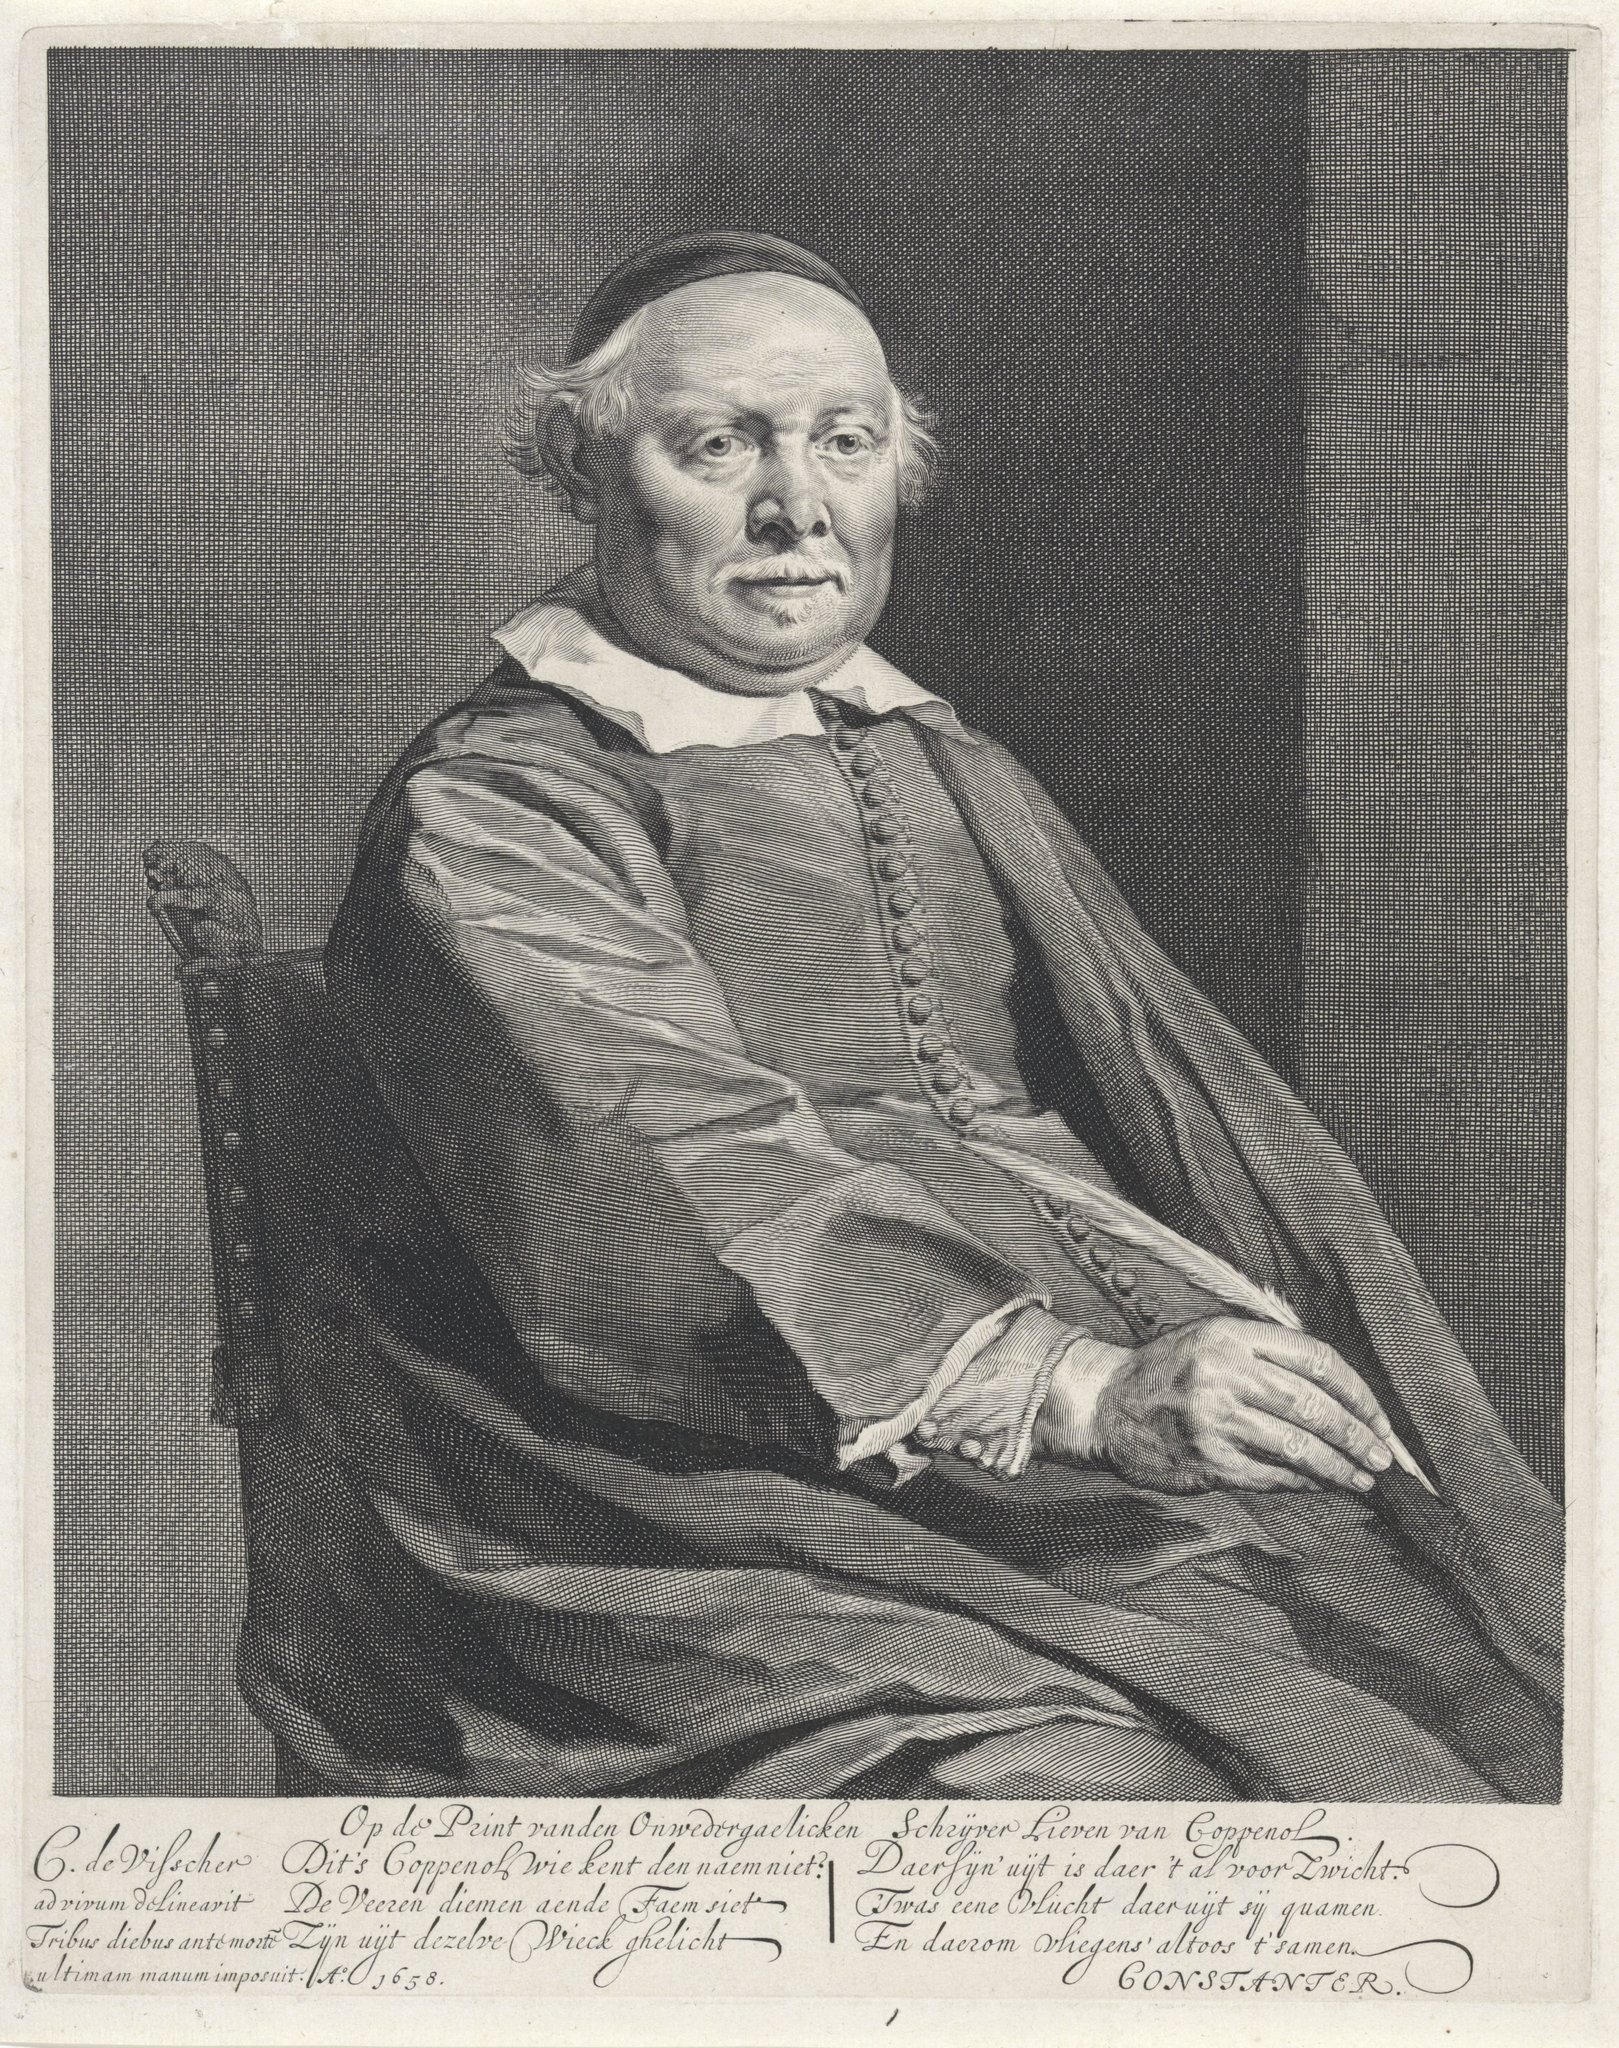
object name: print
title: Portret van Lieven Willemsz. van Coppenol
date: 1658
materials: paper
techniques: engraving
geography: haarlem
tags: amsterdam, draughtsman, lieven willemsz. coppenol, quill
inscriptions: collector's mark: Lugt 240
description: De Amsterdamse schrijfmeester Lieven Willemsz. van Coppenol. De schoonschrijver zit in een vertrek op een stoel met een schrijfveer in zijn hand.